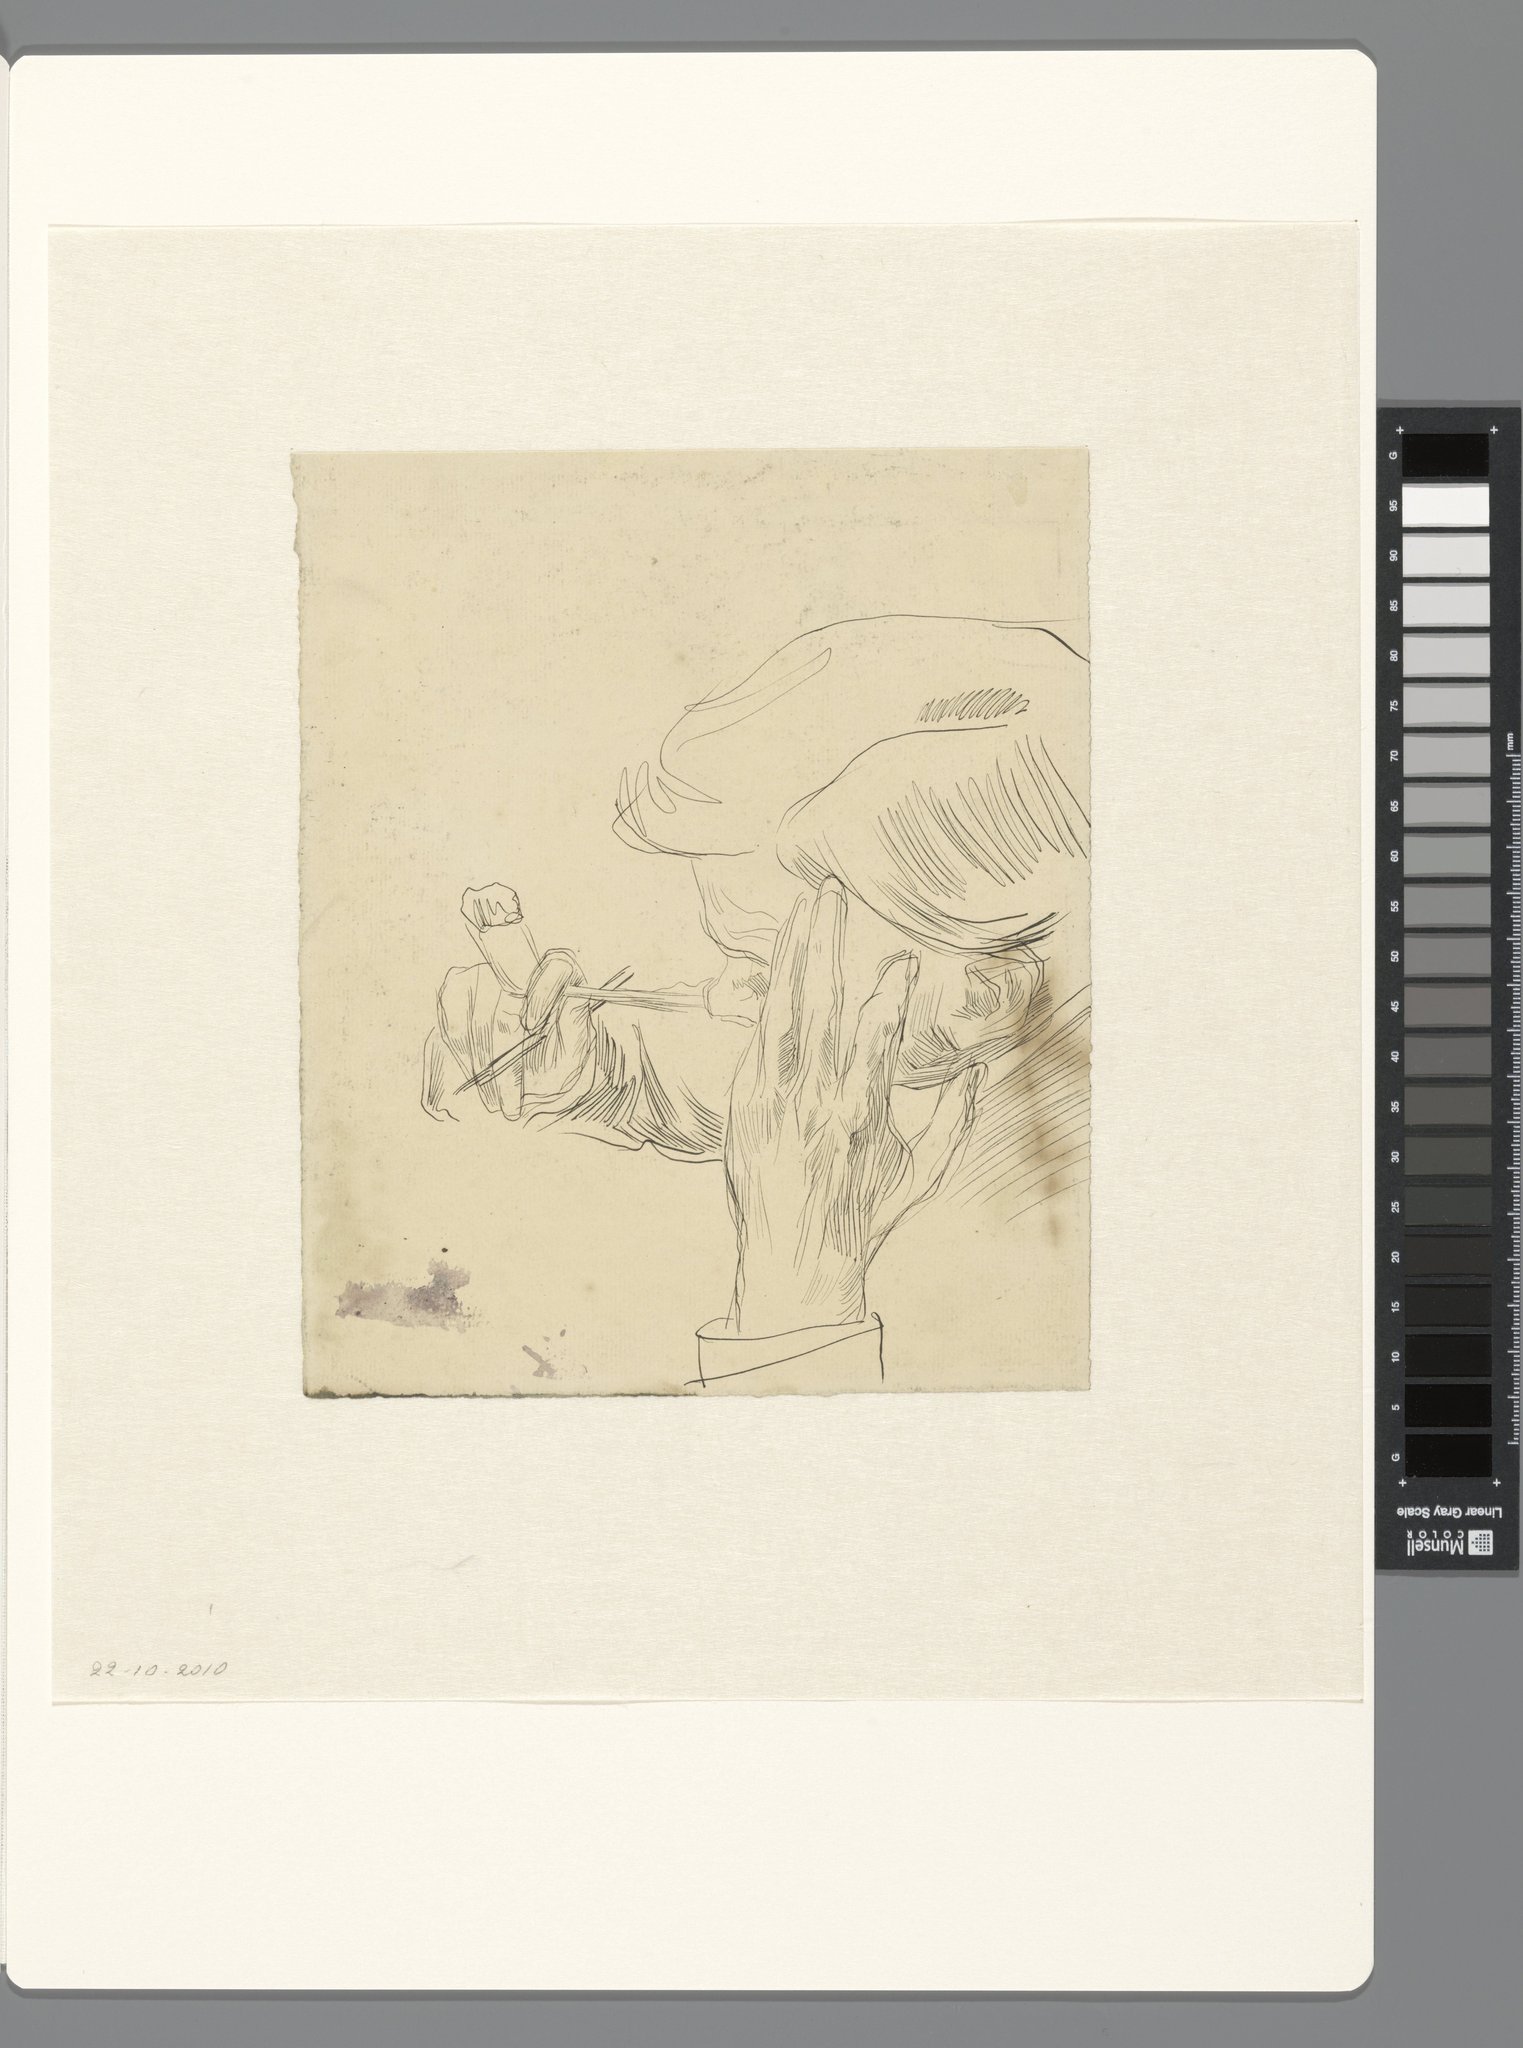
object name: drawing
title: Frederik van Eeden, schrijvend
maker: jan veth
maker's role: designer, draughtsman, painter, print maker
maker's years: 1864-1925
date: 1874-1925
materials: ink, paper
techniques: pen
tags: frederik van eeden, handwriting, writing as activity, historical persons